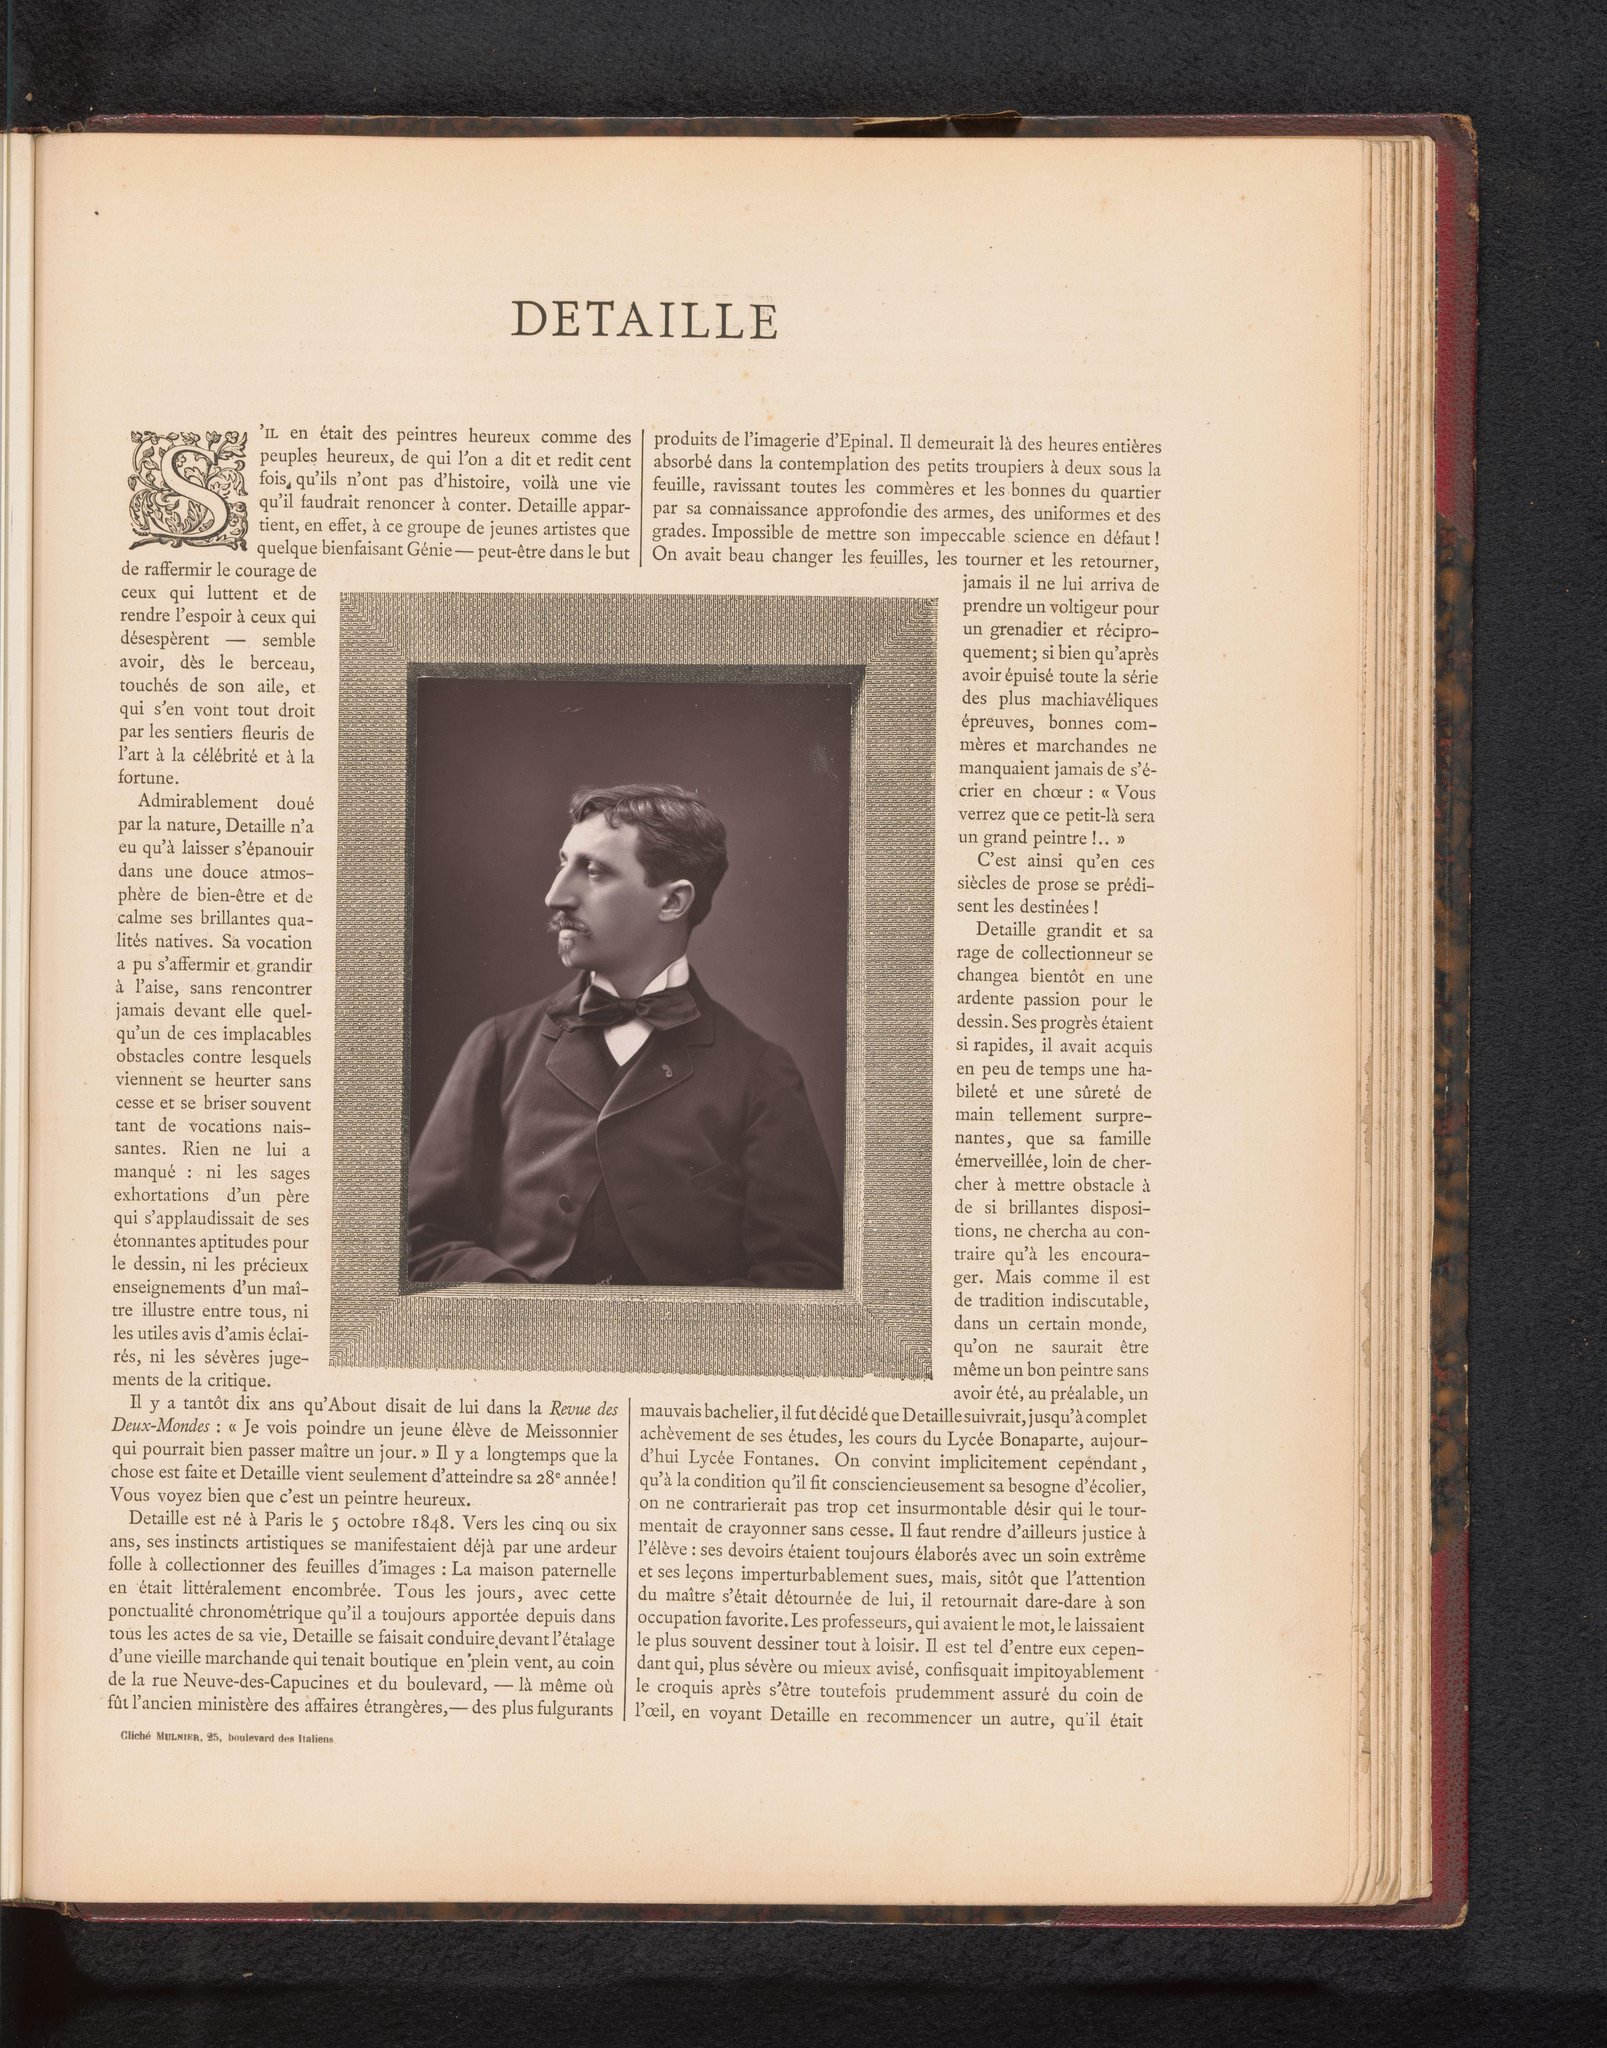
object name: photomechanical print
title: Detaille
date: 1871-1876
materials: paper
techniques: woodburytype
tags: paris, painter, print maker, edouard detaille, adult man, historical persons